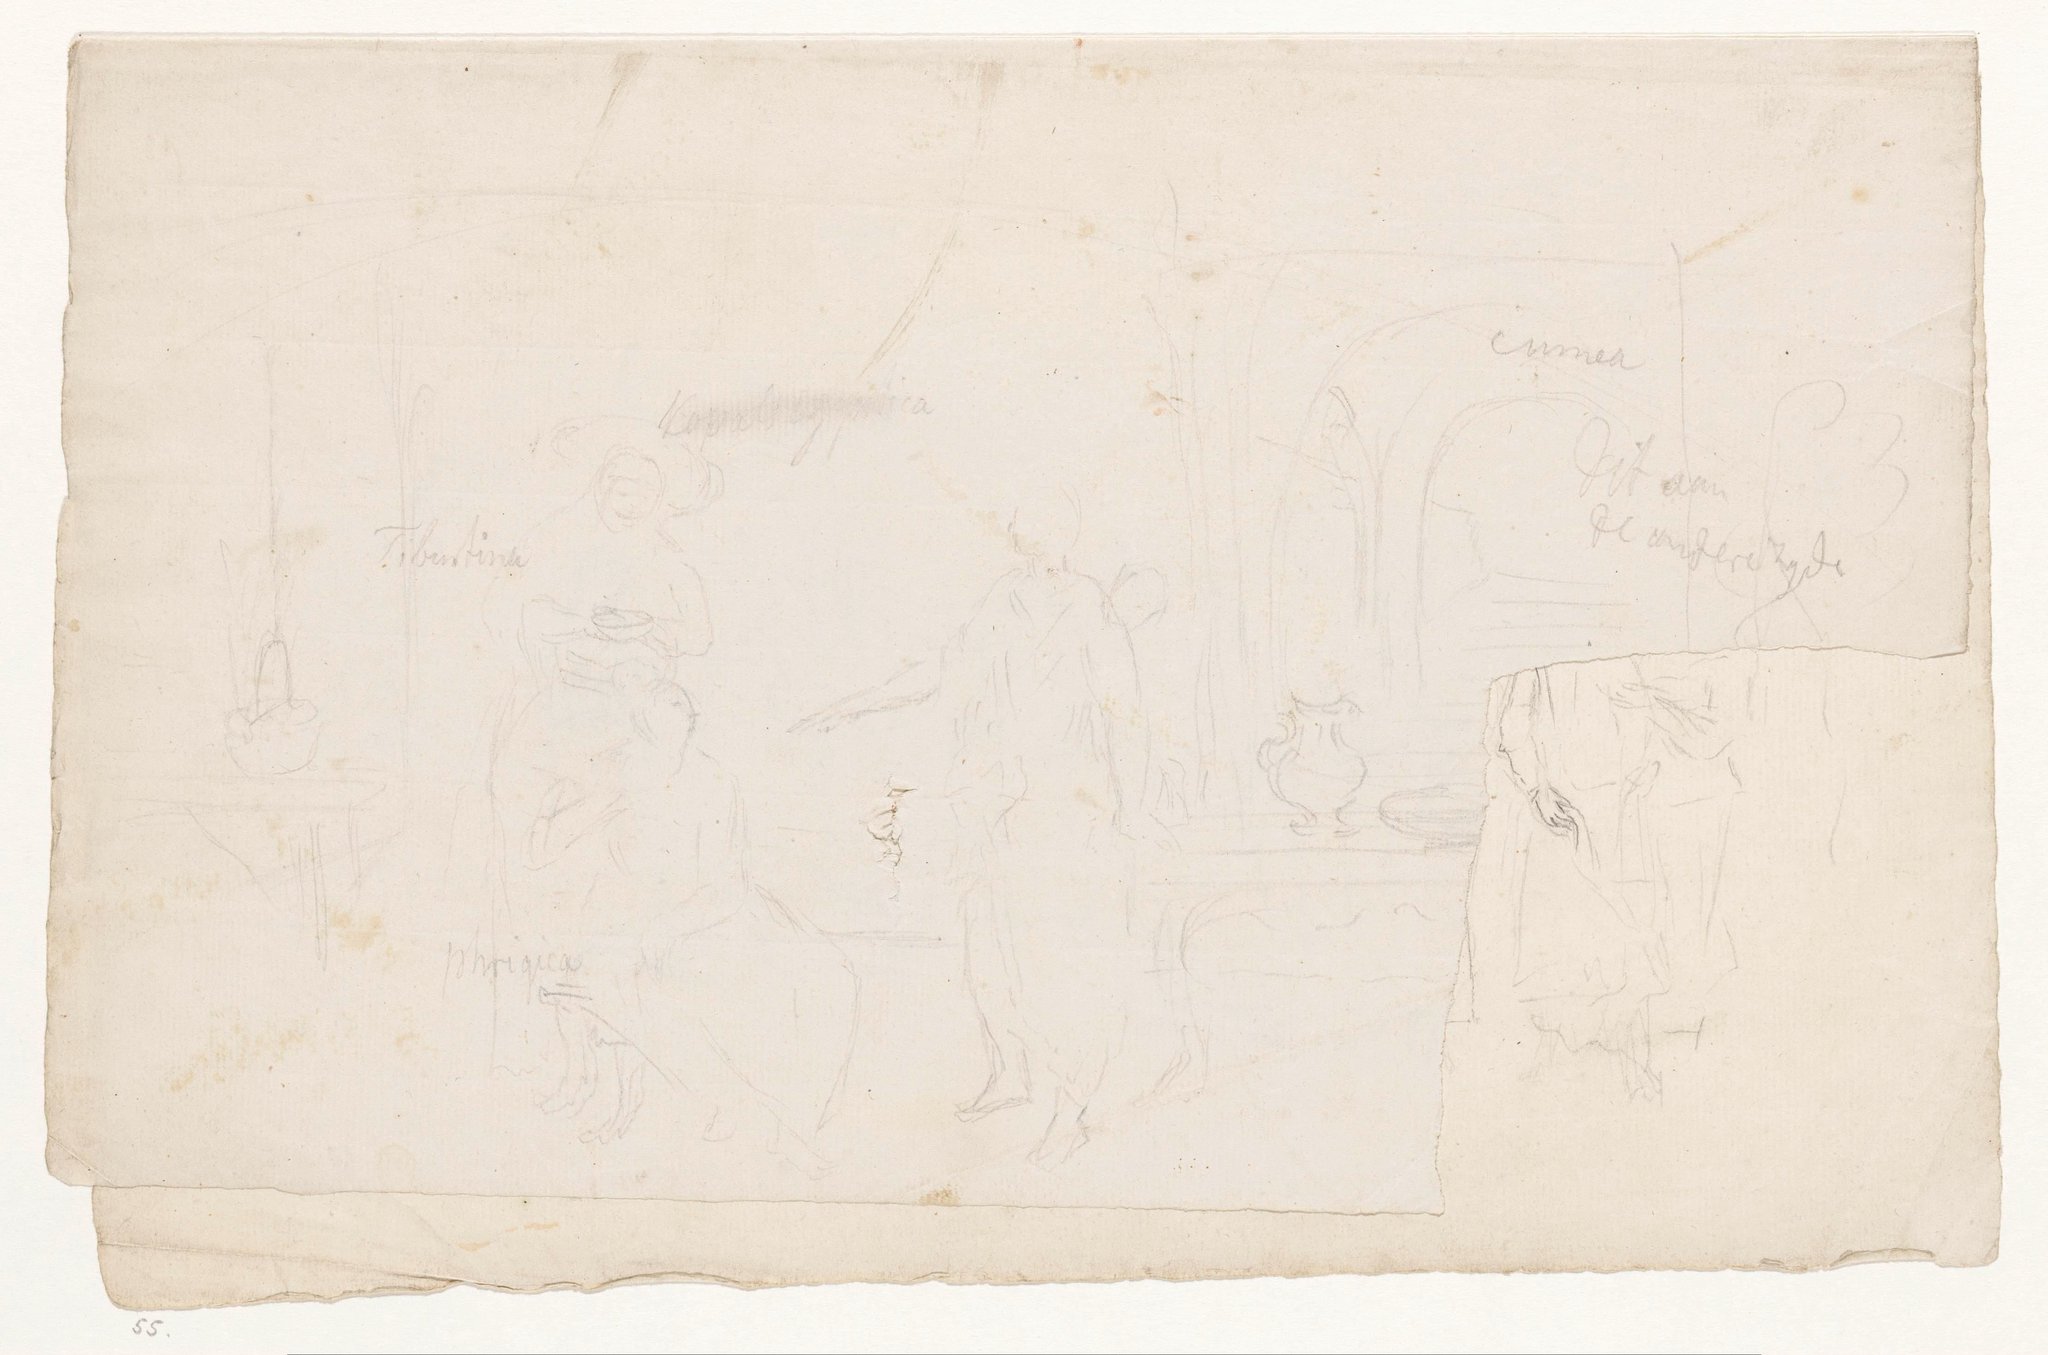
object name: drawing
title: Schetsblad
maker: jan brandes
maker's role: draughtsman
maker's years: 1743-1808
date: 1770-1787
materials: paper, pencil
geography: netherlands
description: Dubbelgevouwen blad met verschillende schetsen. Enkele figuren met de namen van de sibillen Tibertina, Phrygia, en Cimea. Ook een schets van een genezing door Christus.